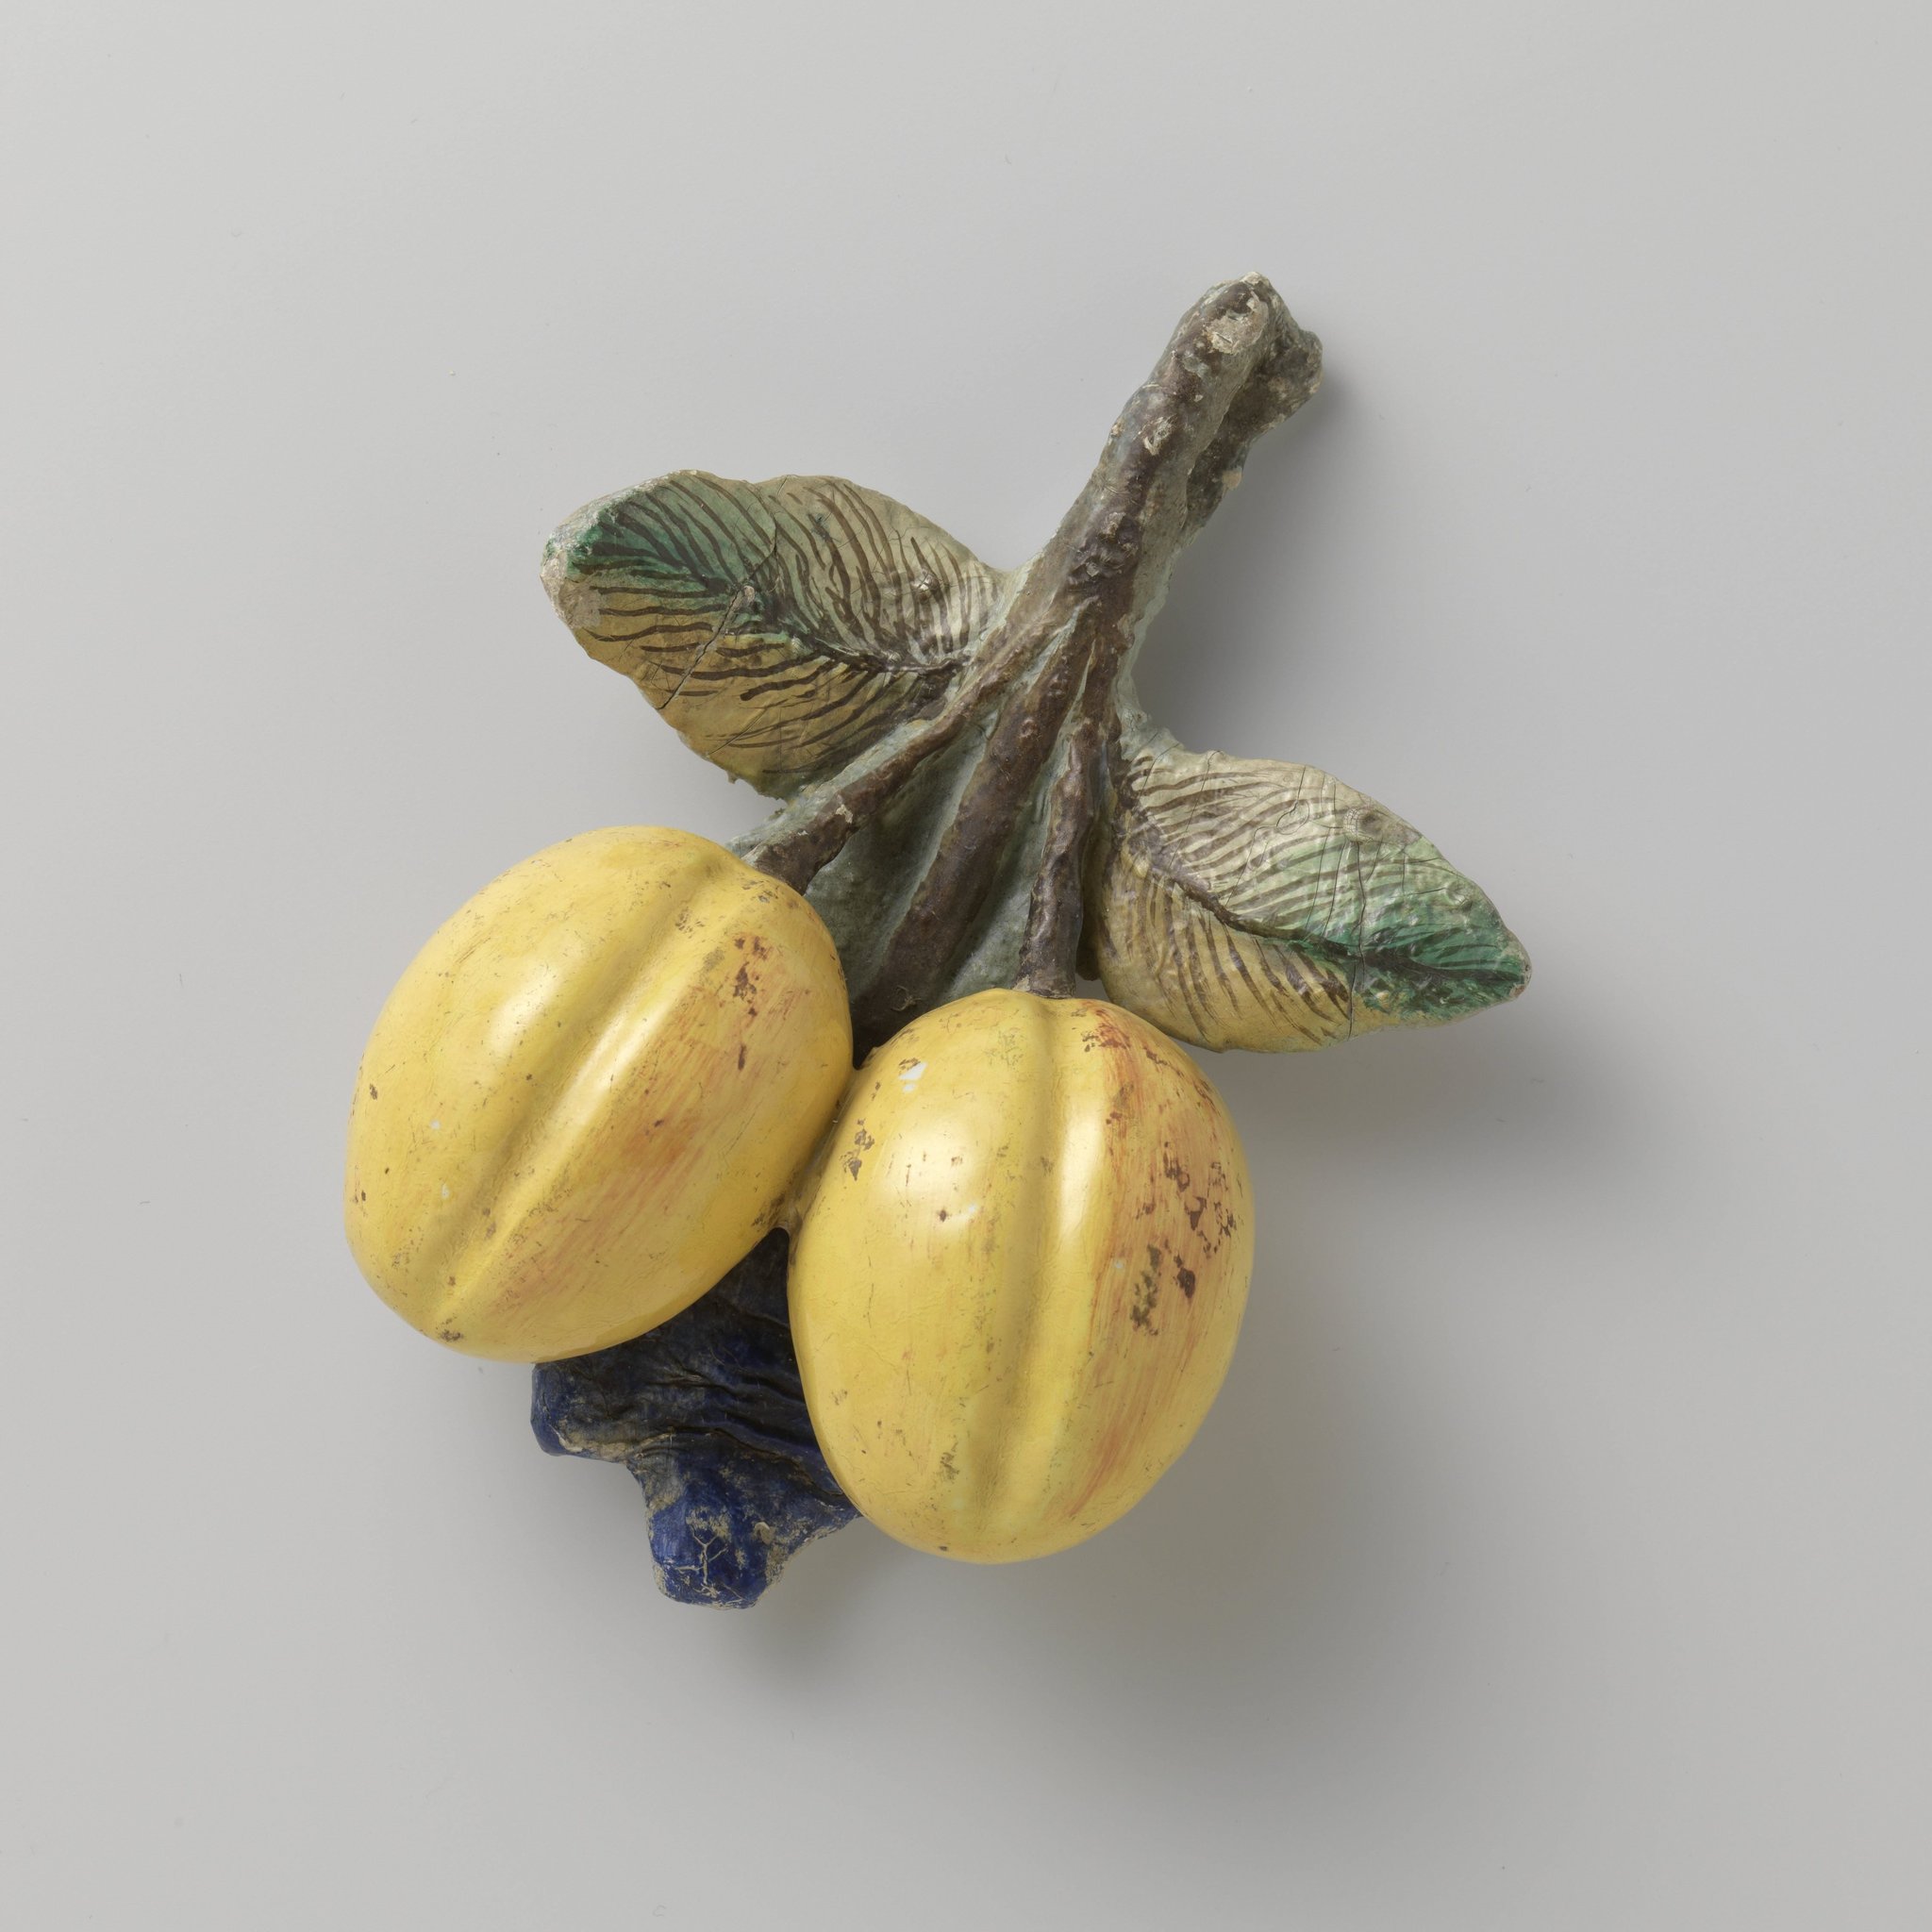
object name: pruim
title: Decoratief object in de vorm van een tros pruimen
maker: Anonymous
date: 1750-1775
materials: faience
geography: delft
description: Decoratief object in de vorm van een tros pruimen.